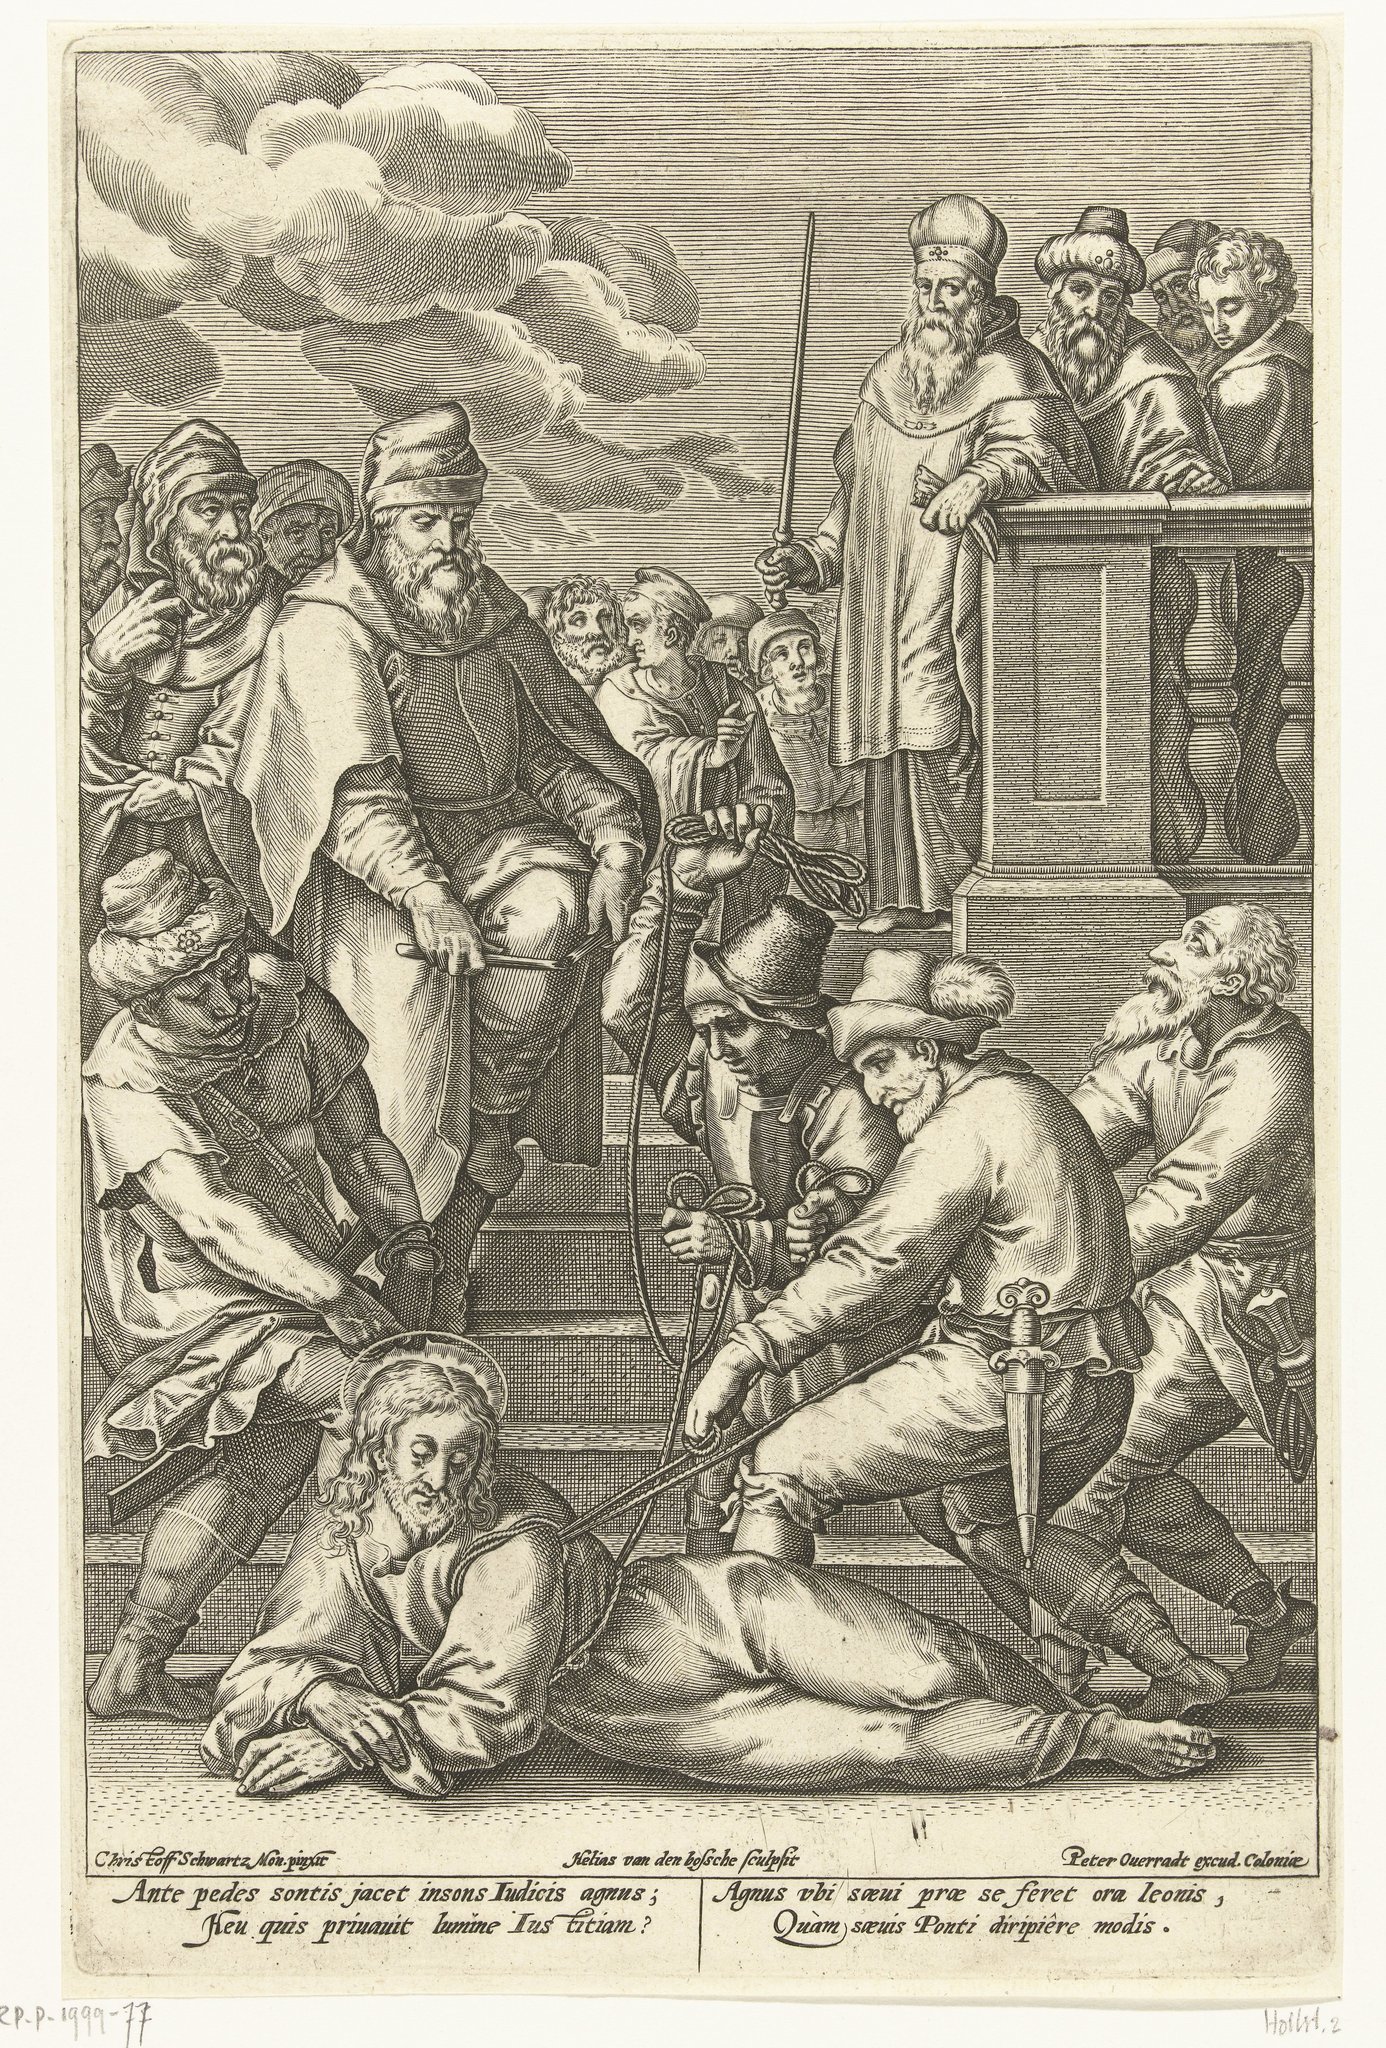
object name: print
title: Passie van Christus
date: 1600-1620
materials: paper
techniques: engraving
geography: cologne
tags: pilate showing christ to the people, 'ostentatio christi', 'ecce homo' (john 19:4-6)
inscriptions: inscription: ‘Ante pedes sontis...Ponti diripiere modis.’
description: Christus ligt gebonden voor de trappen van het Sanhedrin en wordt door een van de soldaten gegeseld met een koord. Op de trap staat Pilatus die zijn staf (gerechtsroede) op zijn knie in tweeën breekt. Met toeschouwers.